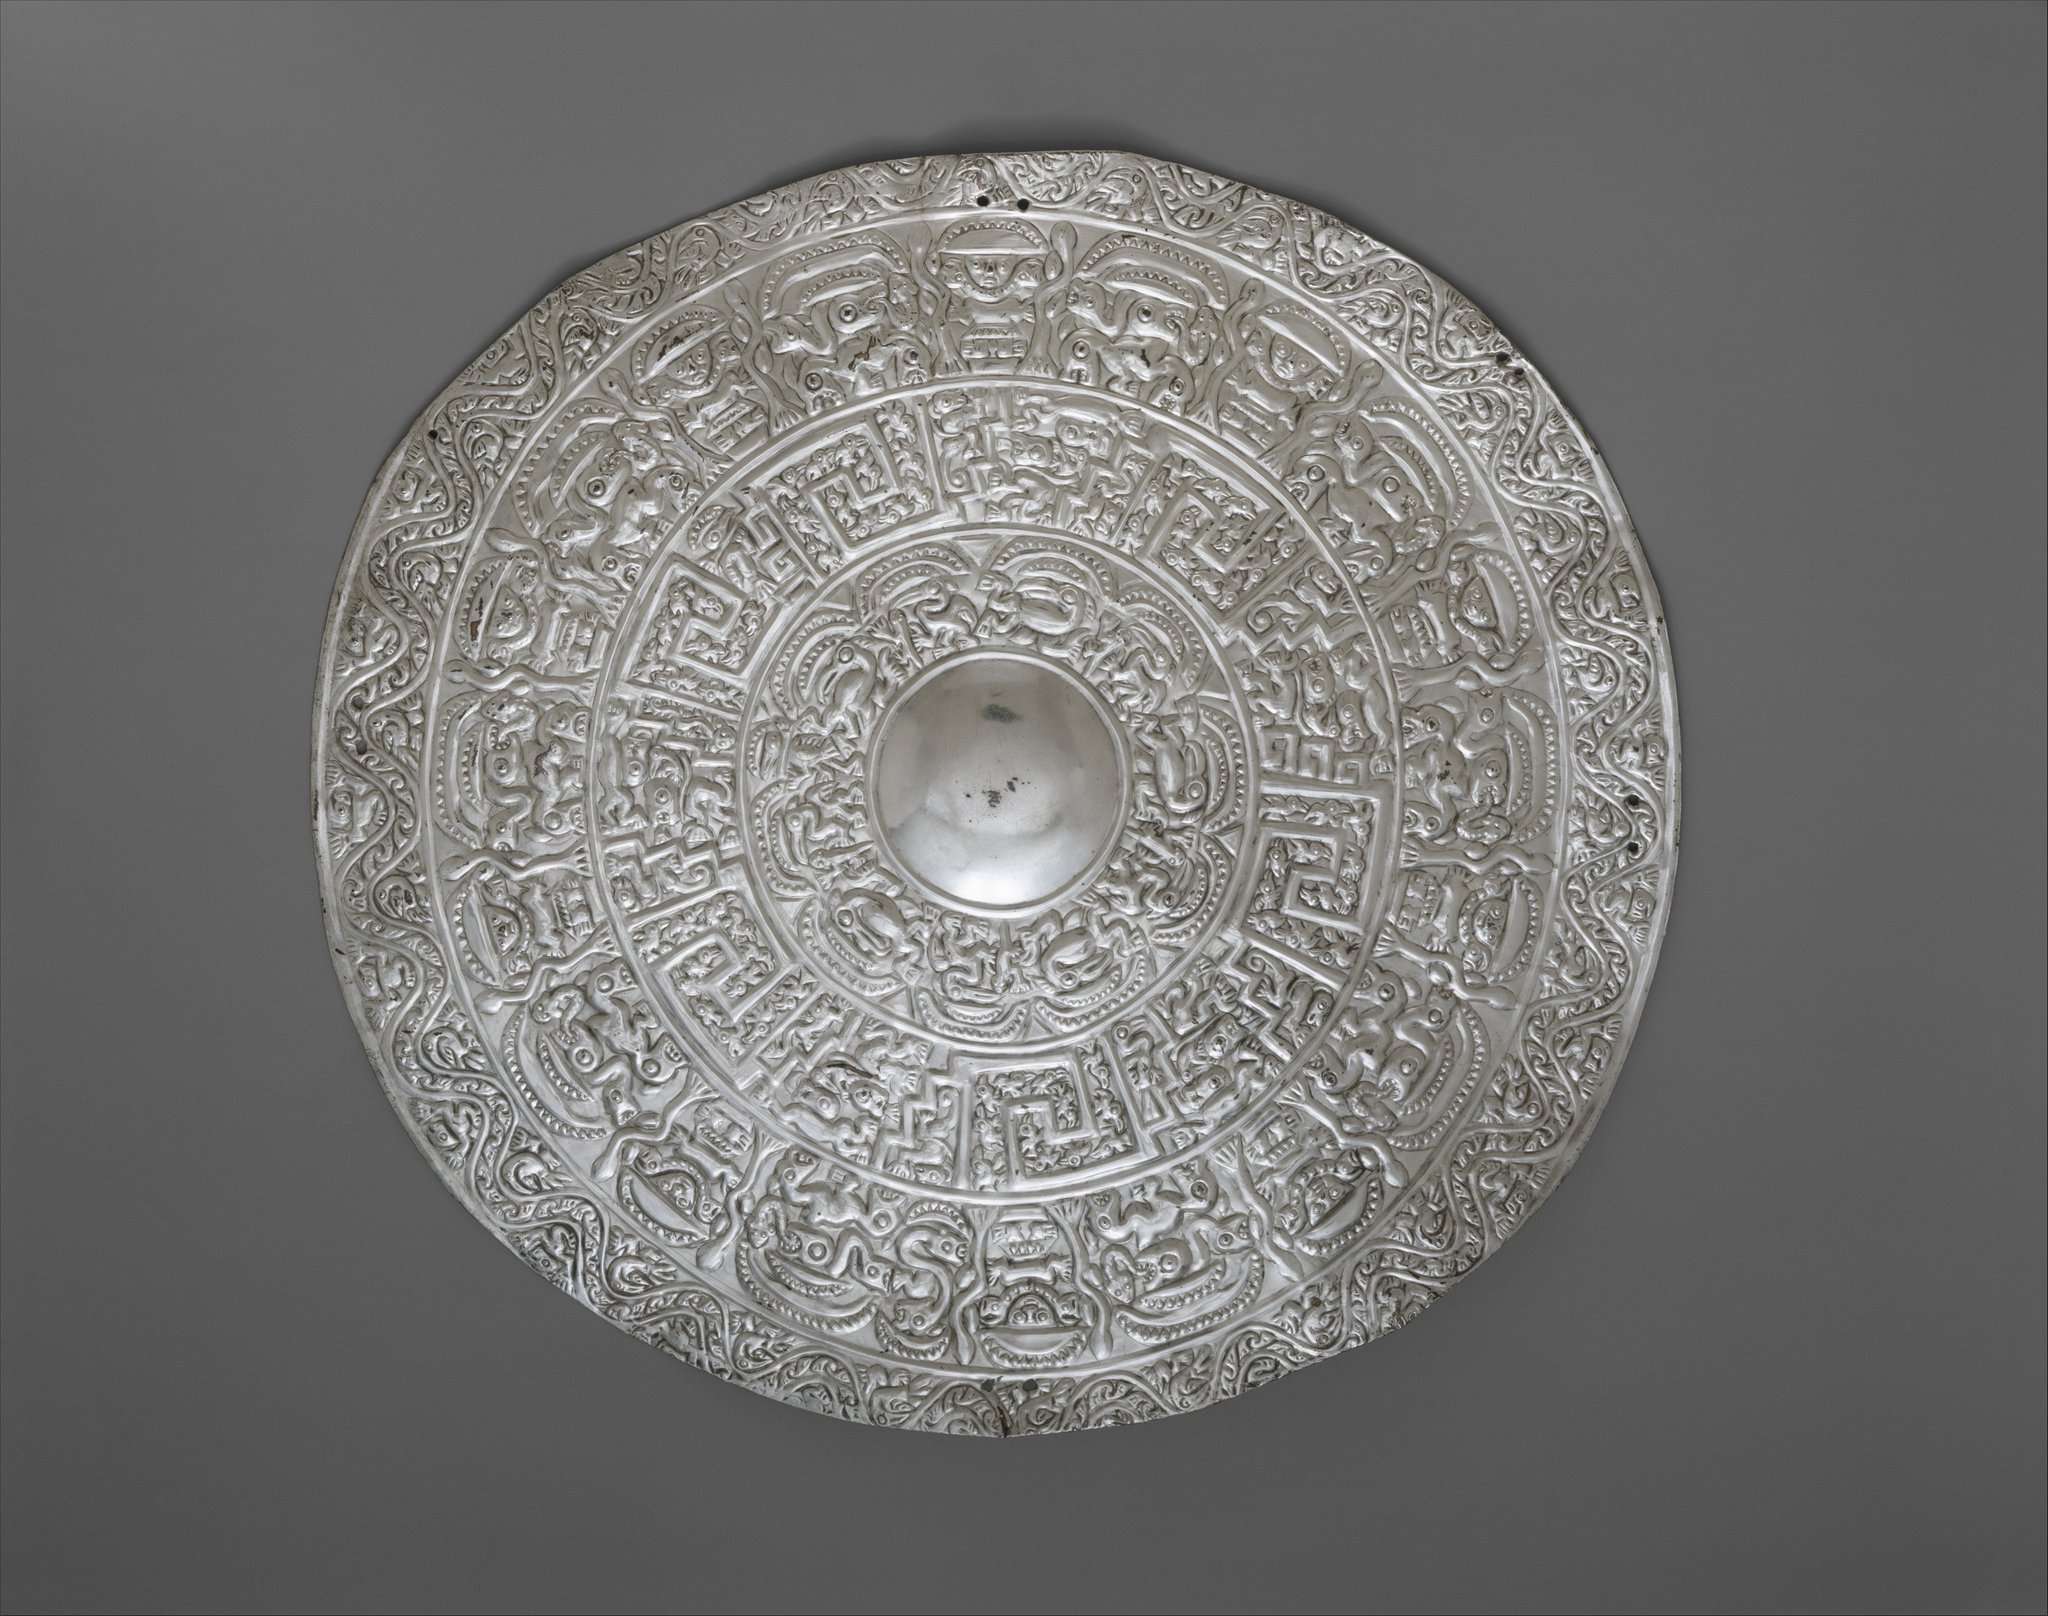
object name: disk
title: Shield cover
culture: chimú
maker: chimú artist(s)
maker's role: artist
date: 1350-1470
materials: silver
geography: peru